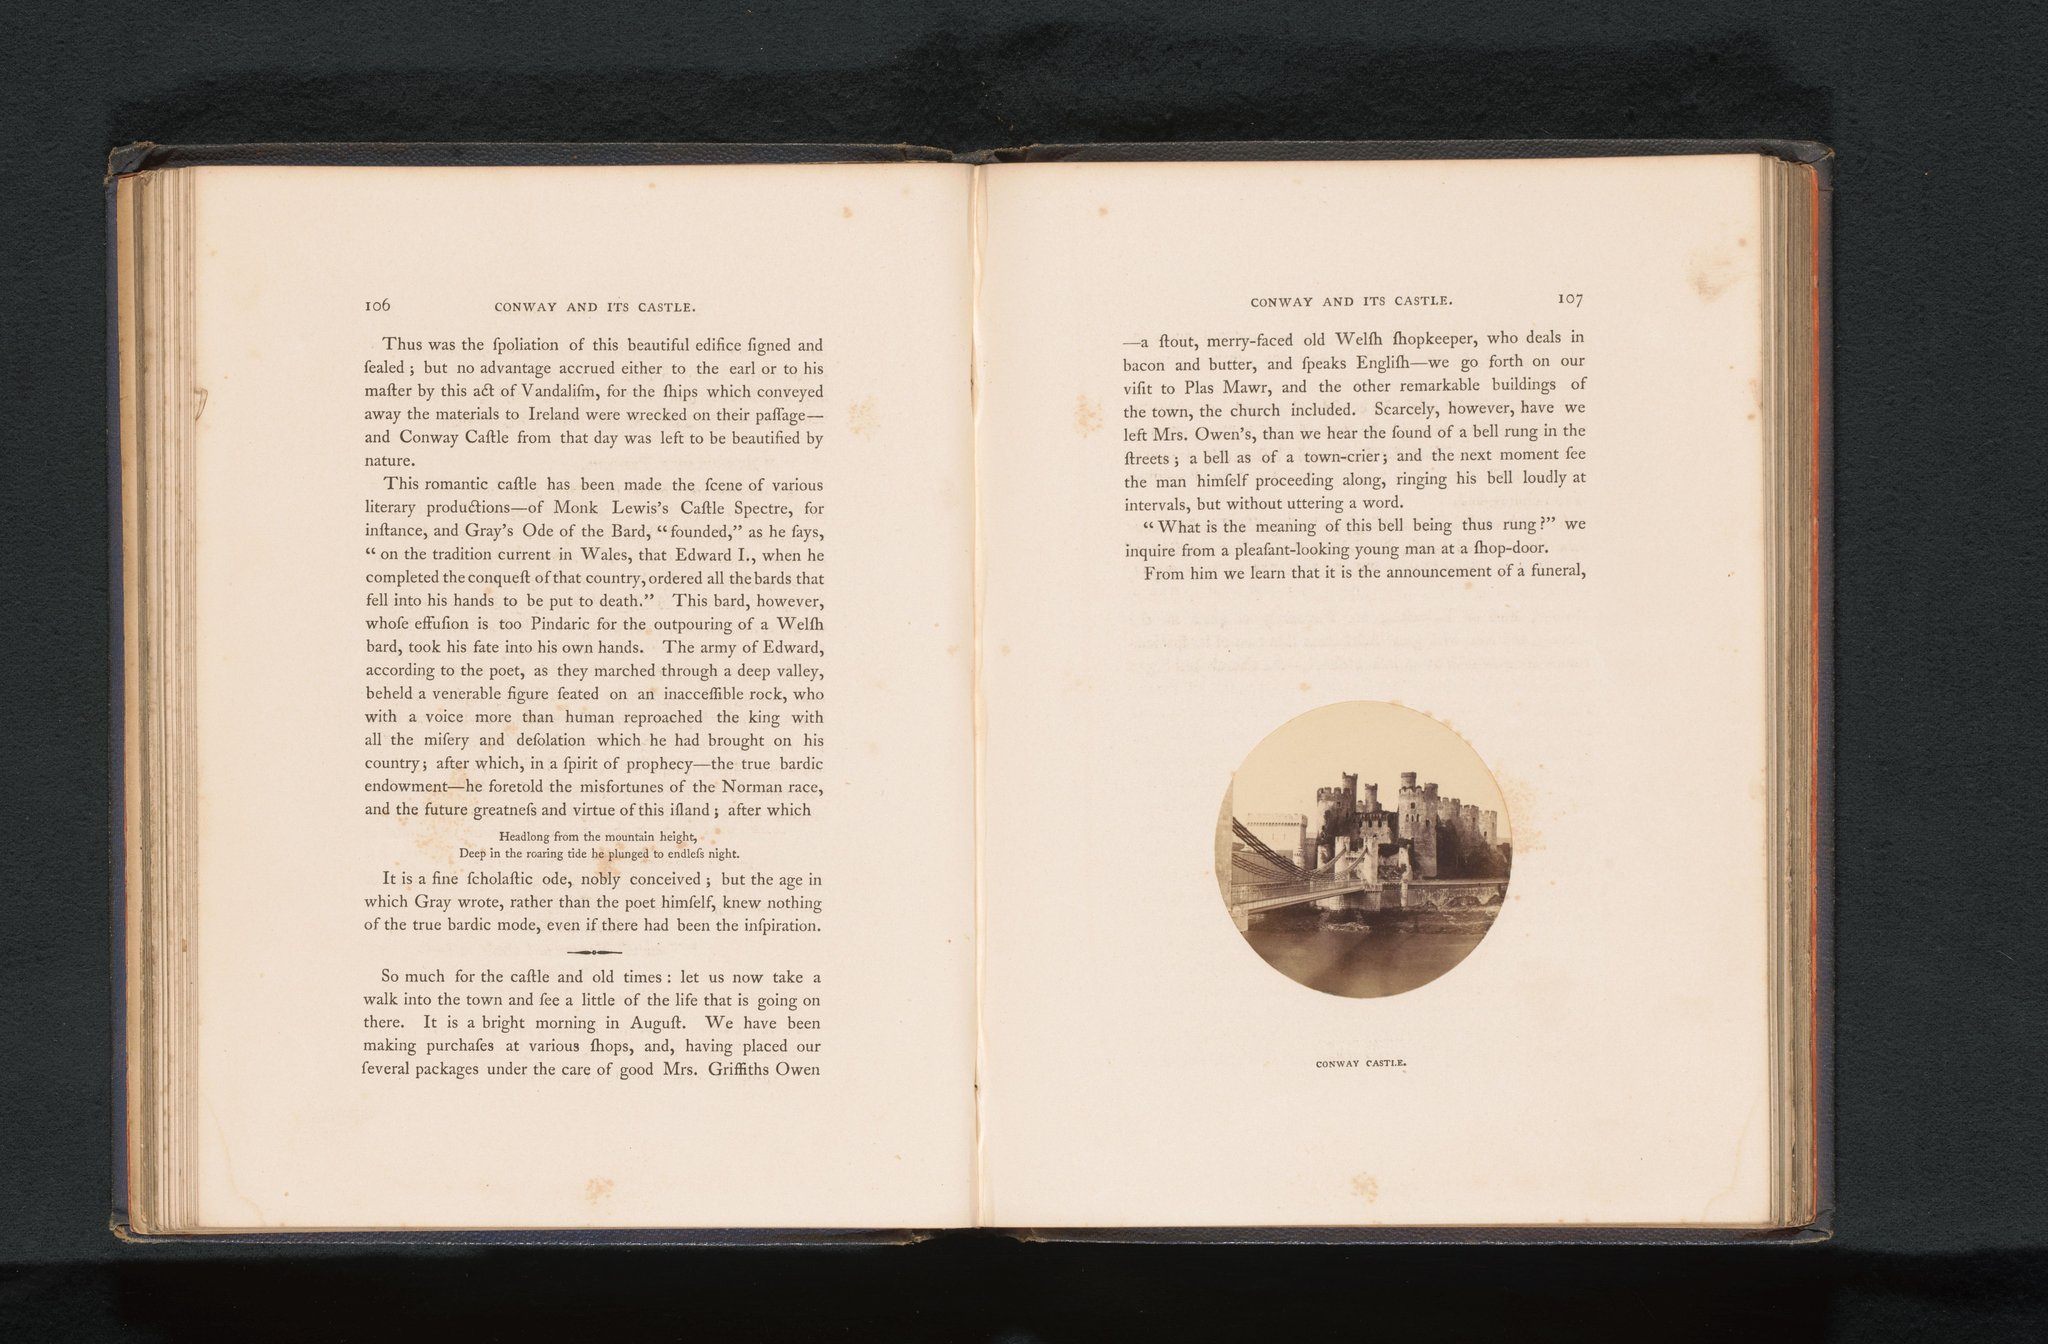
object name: photograph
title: Gezicht op Conwy Castle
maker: william russell sedgfield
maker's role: fotograaf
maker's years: 1826-1902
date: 1857-1862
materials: photographic support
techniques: albumen print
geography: conwy castle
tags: ruin of a dwelling, house, castle, etc.